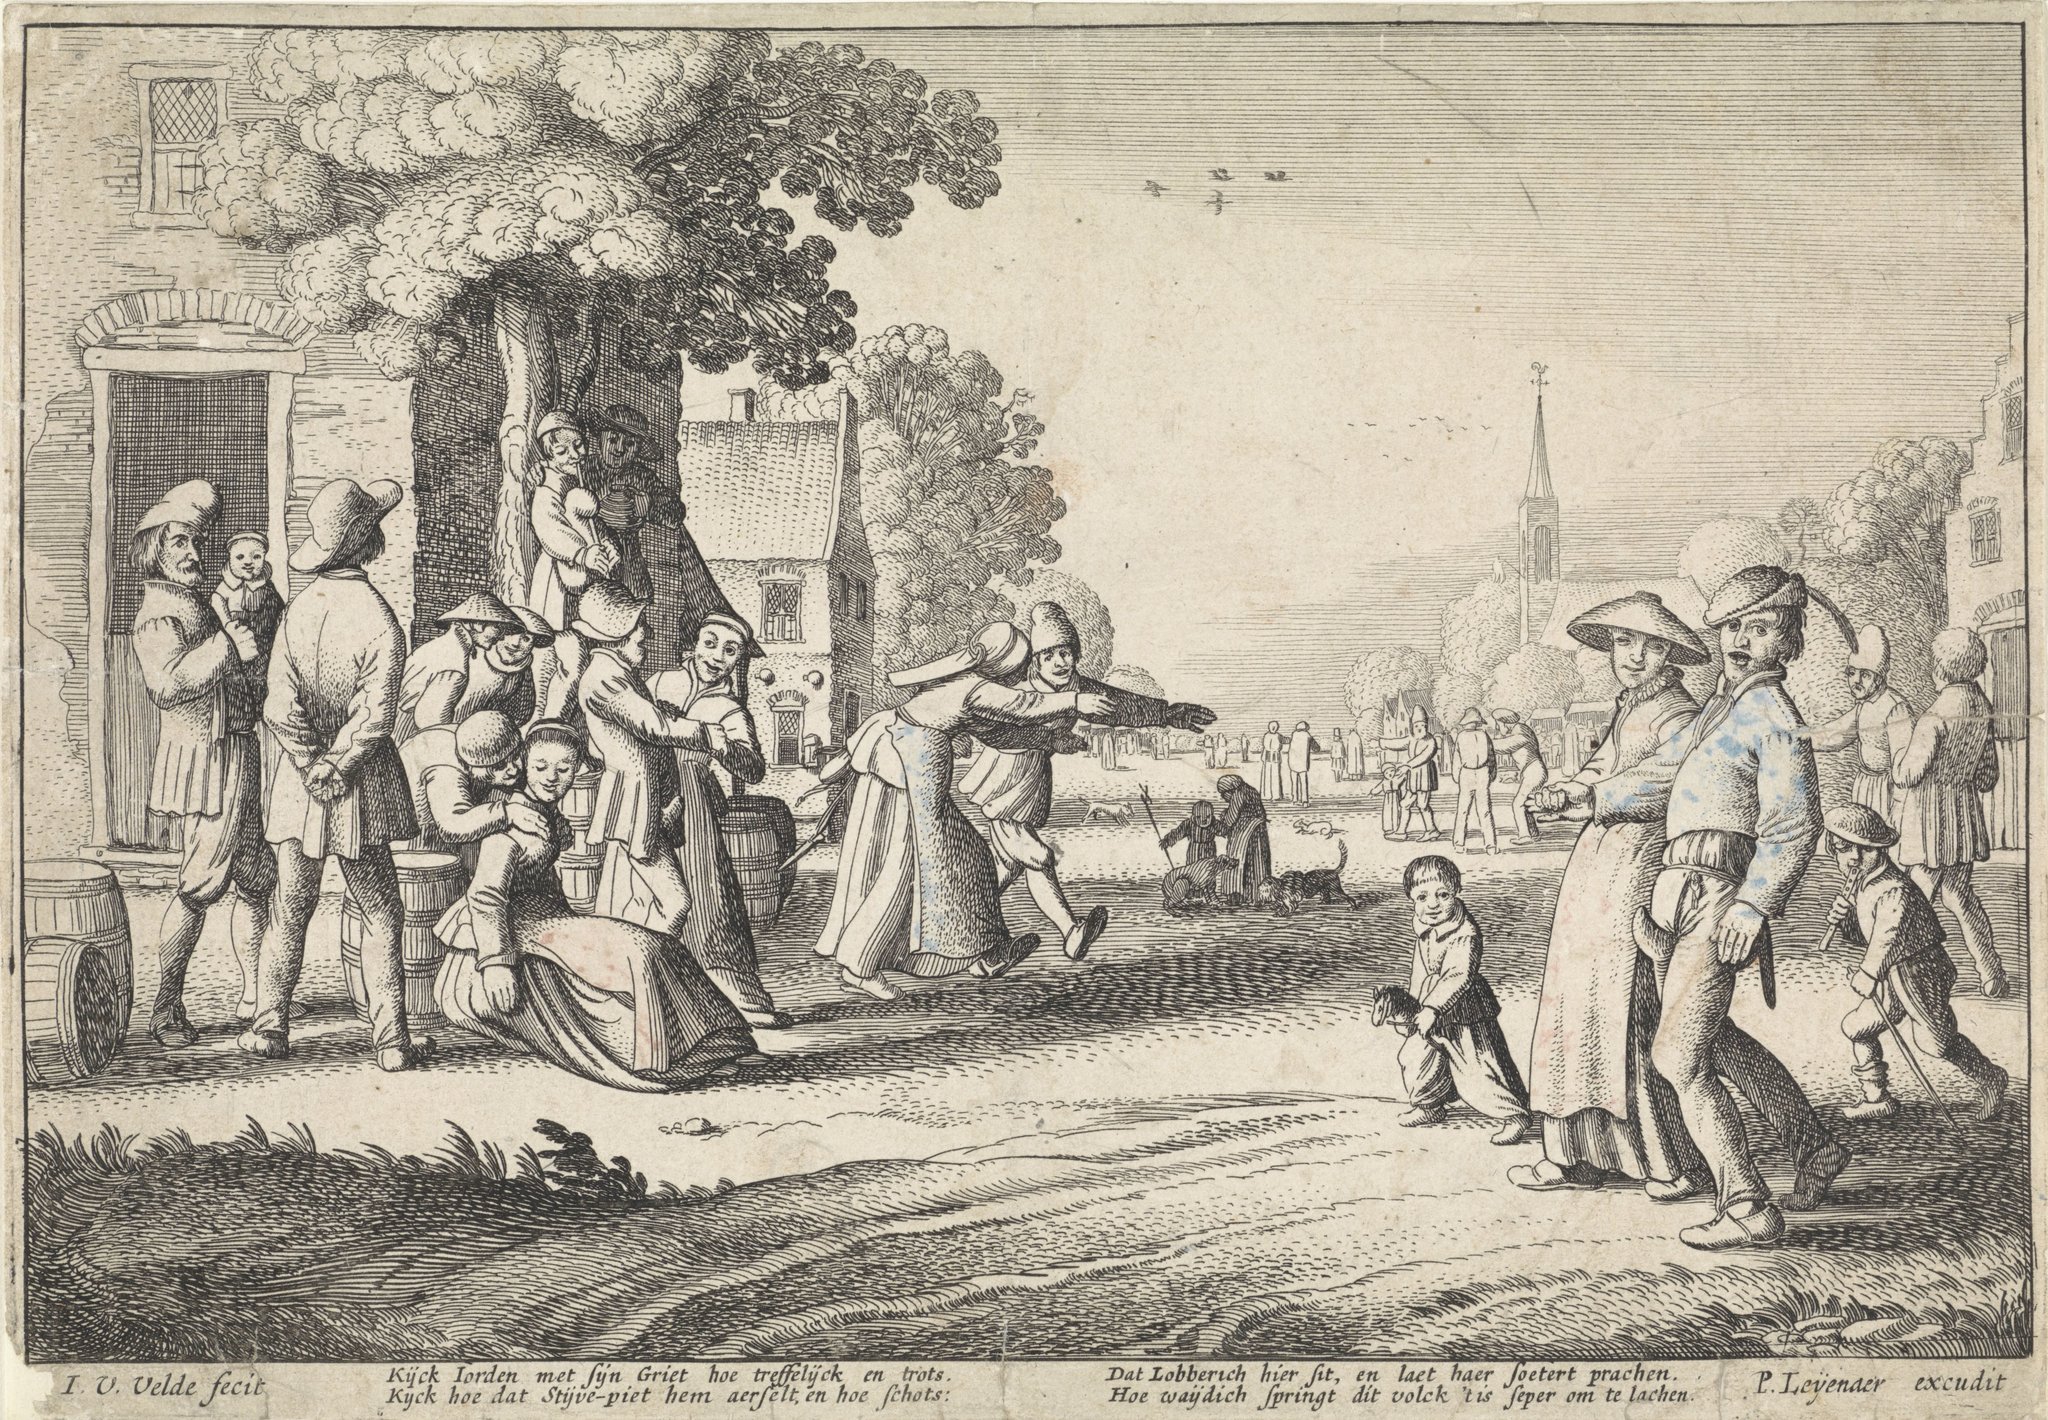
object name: print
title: Dansende boeren tijdens een dorpsfeest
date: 1652-1673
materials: paper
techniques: etching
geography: northern netherlands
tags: farmers, performance in the open air (pleasure fair), bagpipe, musette - cc - out of doors, more than one couple dancing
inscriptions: collector's mark: Lugt 964, collector's mark: Lugt 240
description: Dansende boeren paren in een dorpsstraat, tijdens een dorpsfeest, op de muziek van een doedelzakspeler die onder een boom staat te spelen. Rechtsvoor een jongetje op een stokpaardje. Rechts op de achtergrond een kerk.